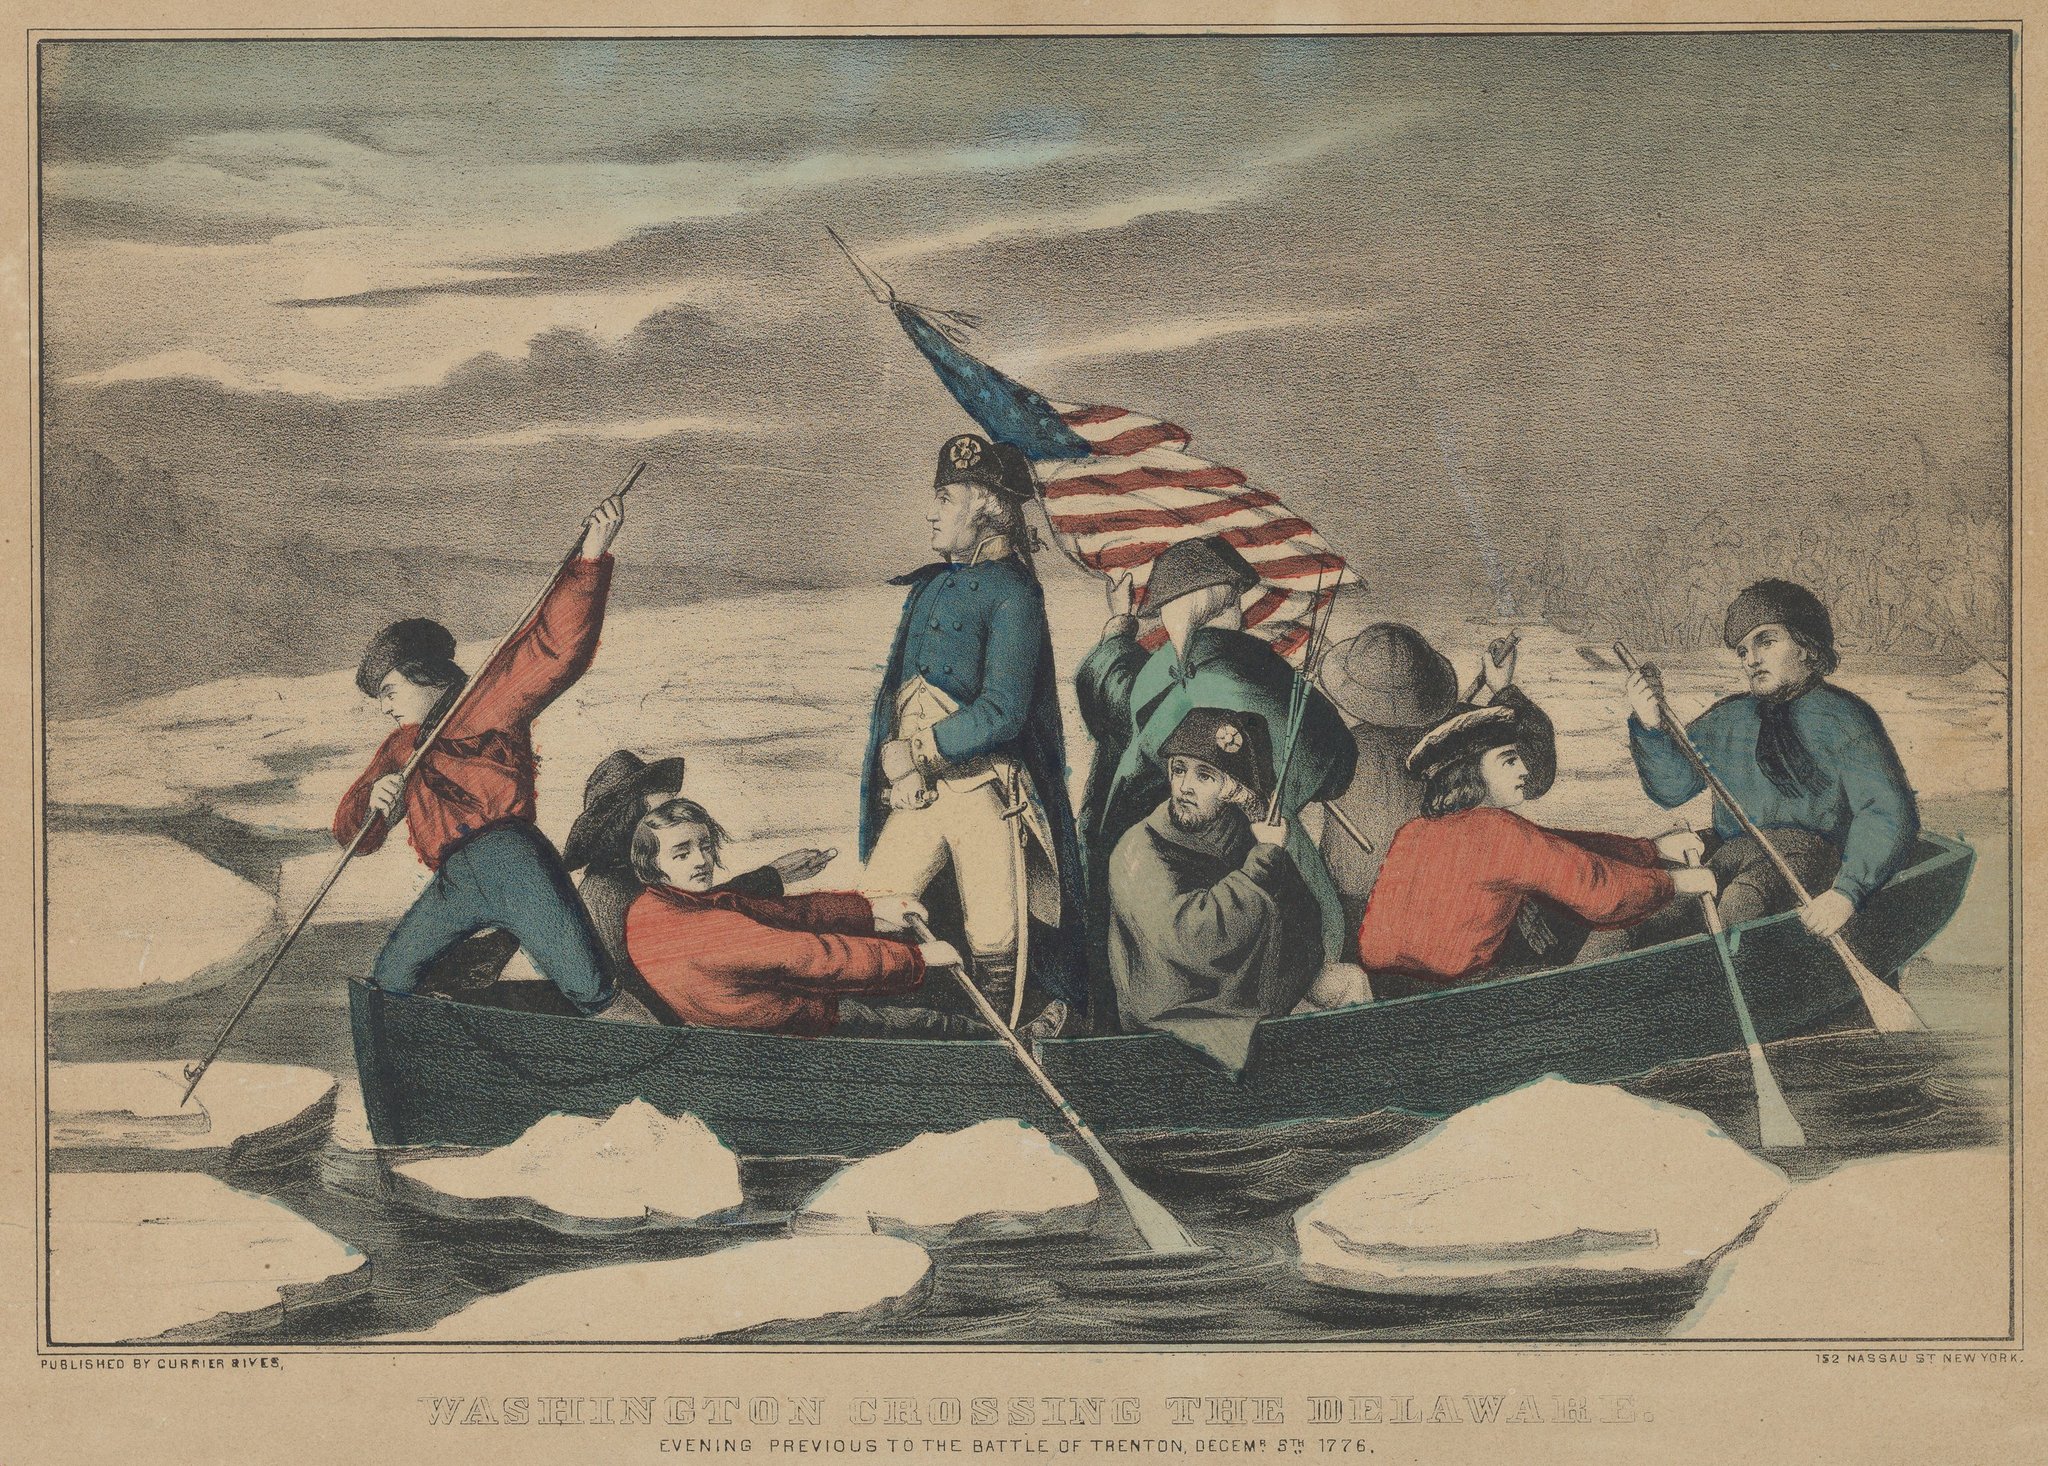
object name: print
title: Washington Crossing the Delaware – Evening Previous to the Battle of Trenton, December 5th, 1776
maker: currier & ives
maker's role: publisher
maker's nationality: american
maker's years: 1857-1907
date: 1857-1871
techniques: hand coloring, lithograph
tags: soldiers,american revolution,george washington,flags,boats